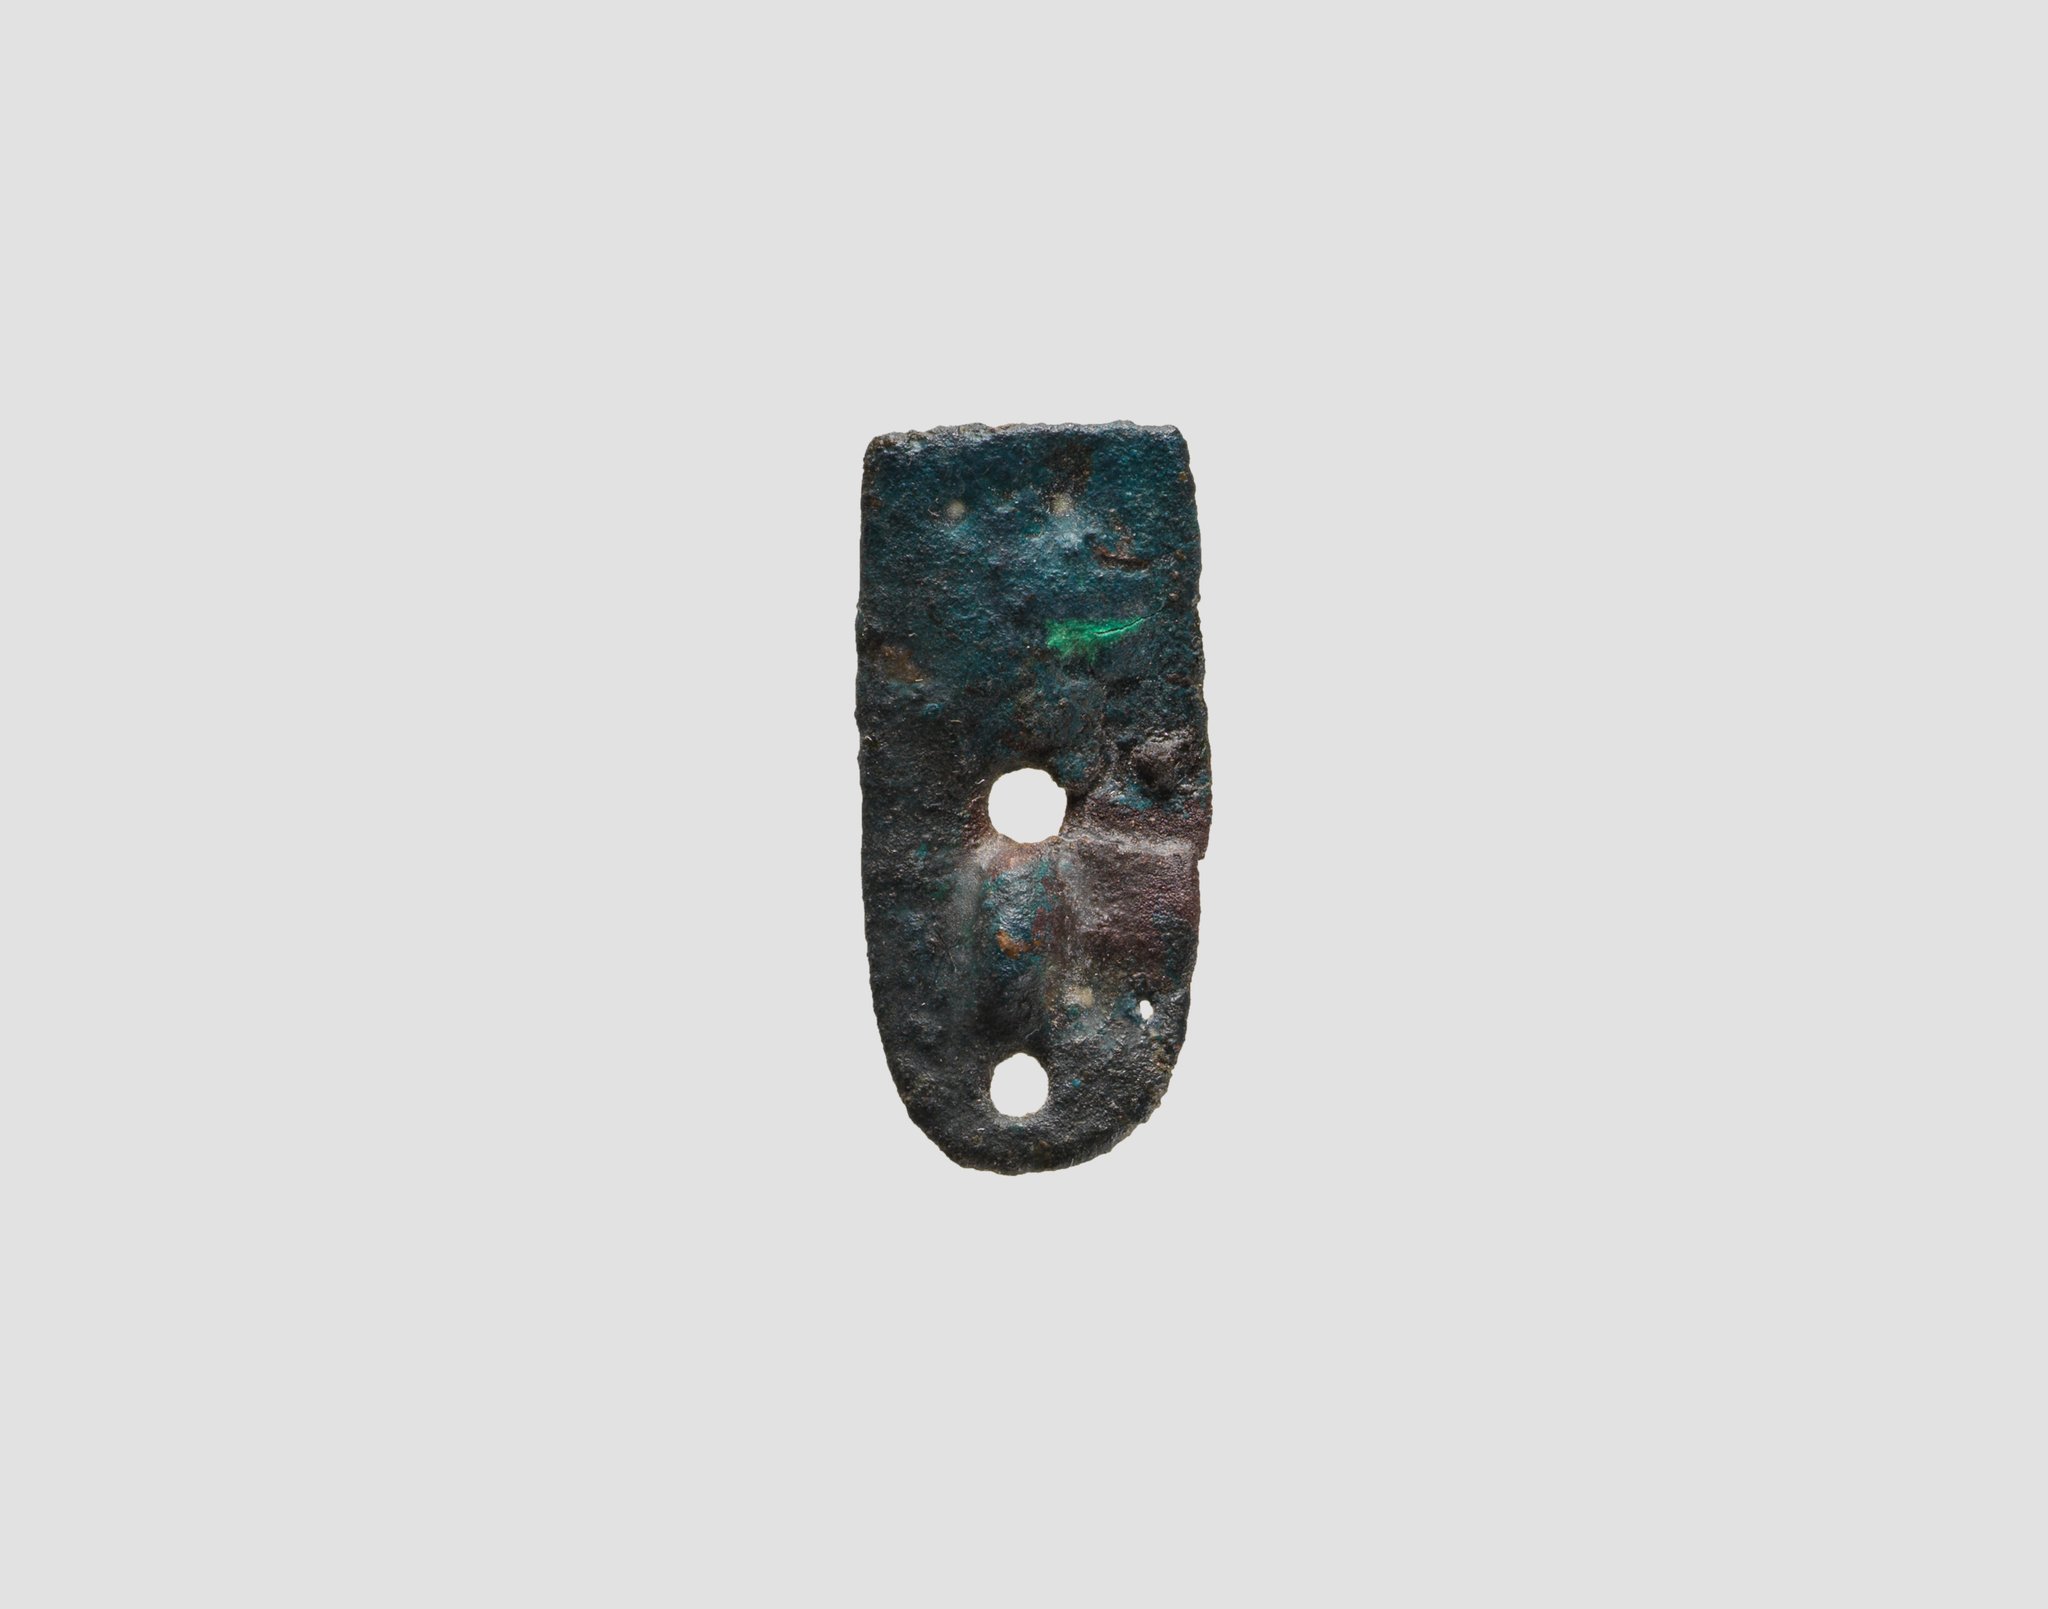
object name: armor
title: Armor plate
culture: assyrian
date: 734-601 BCE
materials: bronze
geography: mesopotamia